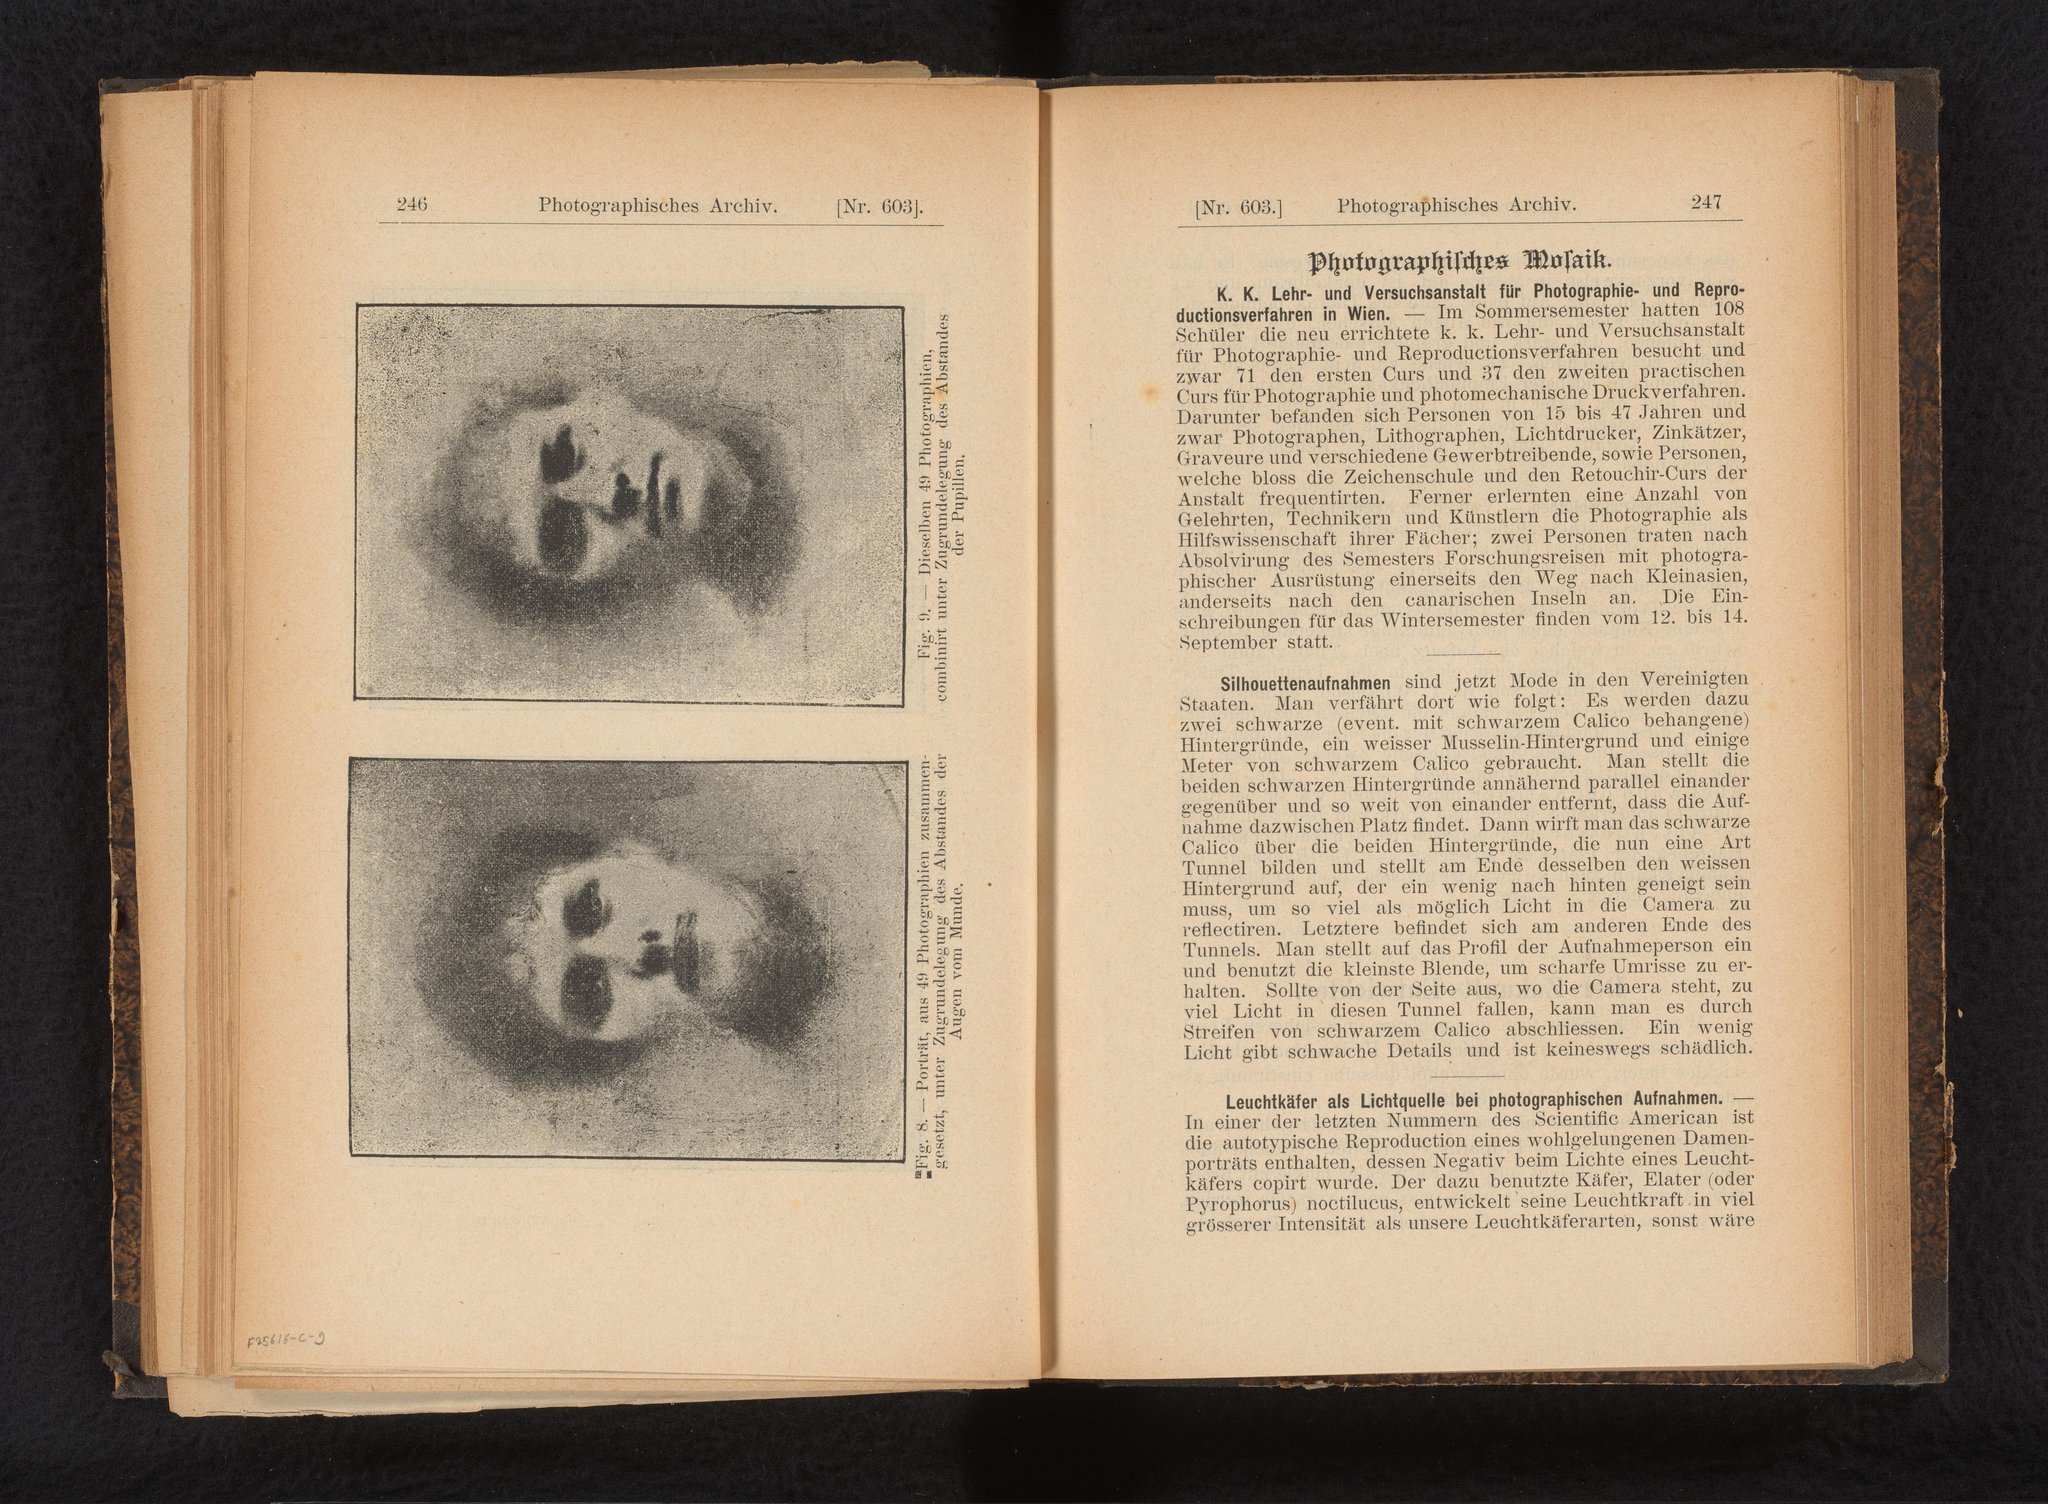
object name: photomechanical print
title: Twee samengestelde portretten van onbekende personen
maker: Anonymous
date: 1883-1888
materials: paper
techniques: autotype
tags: historical persons not known by name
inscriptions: inscription: ‘Fig. 8. - Porträt, aus 49 Photographien zusammengesetzt, unter Zugrundelegung des Abstandes der Augen von Munde. Fig. 9. - Dieselben 49 Photographien, combinirt unter Zugrundelegung des Abstandes der Pupillen.’